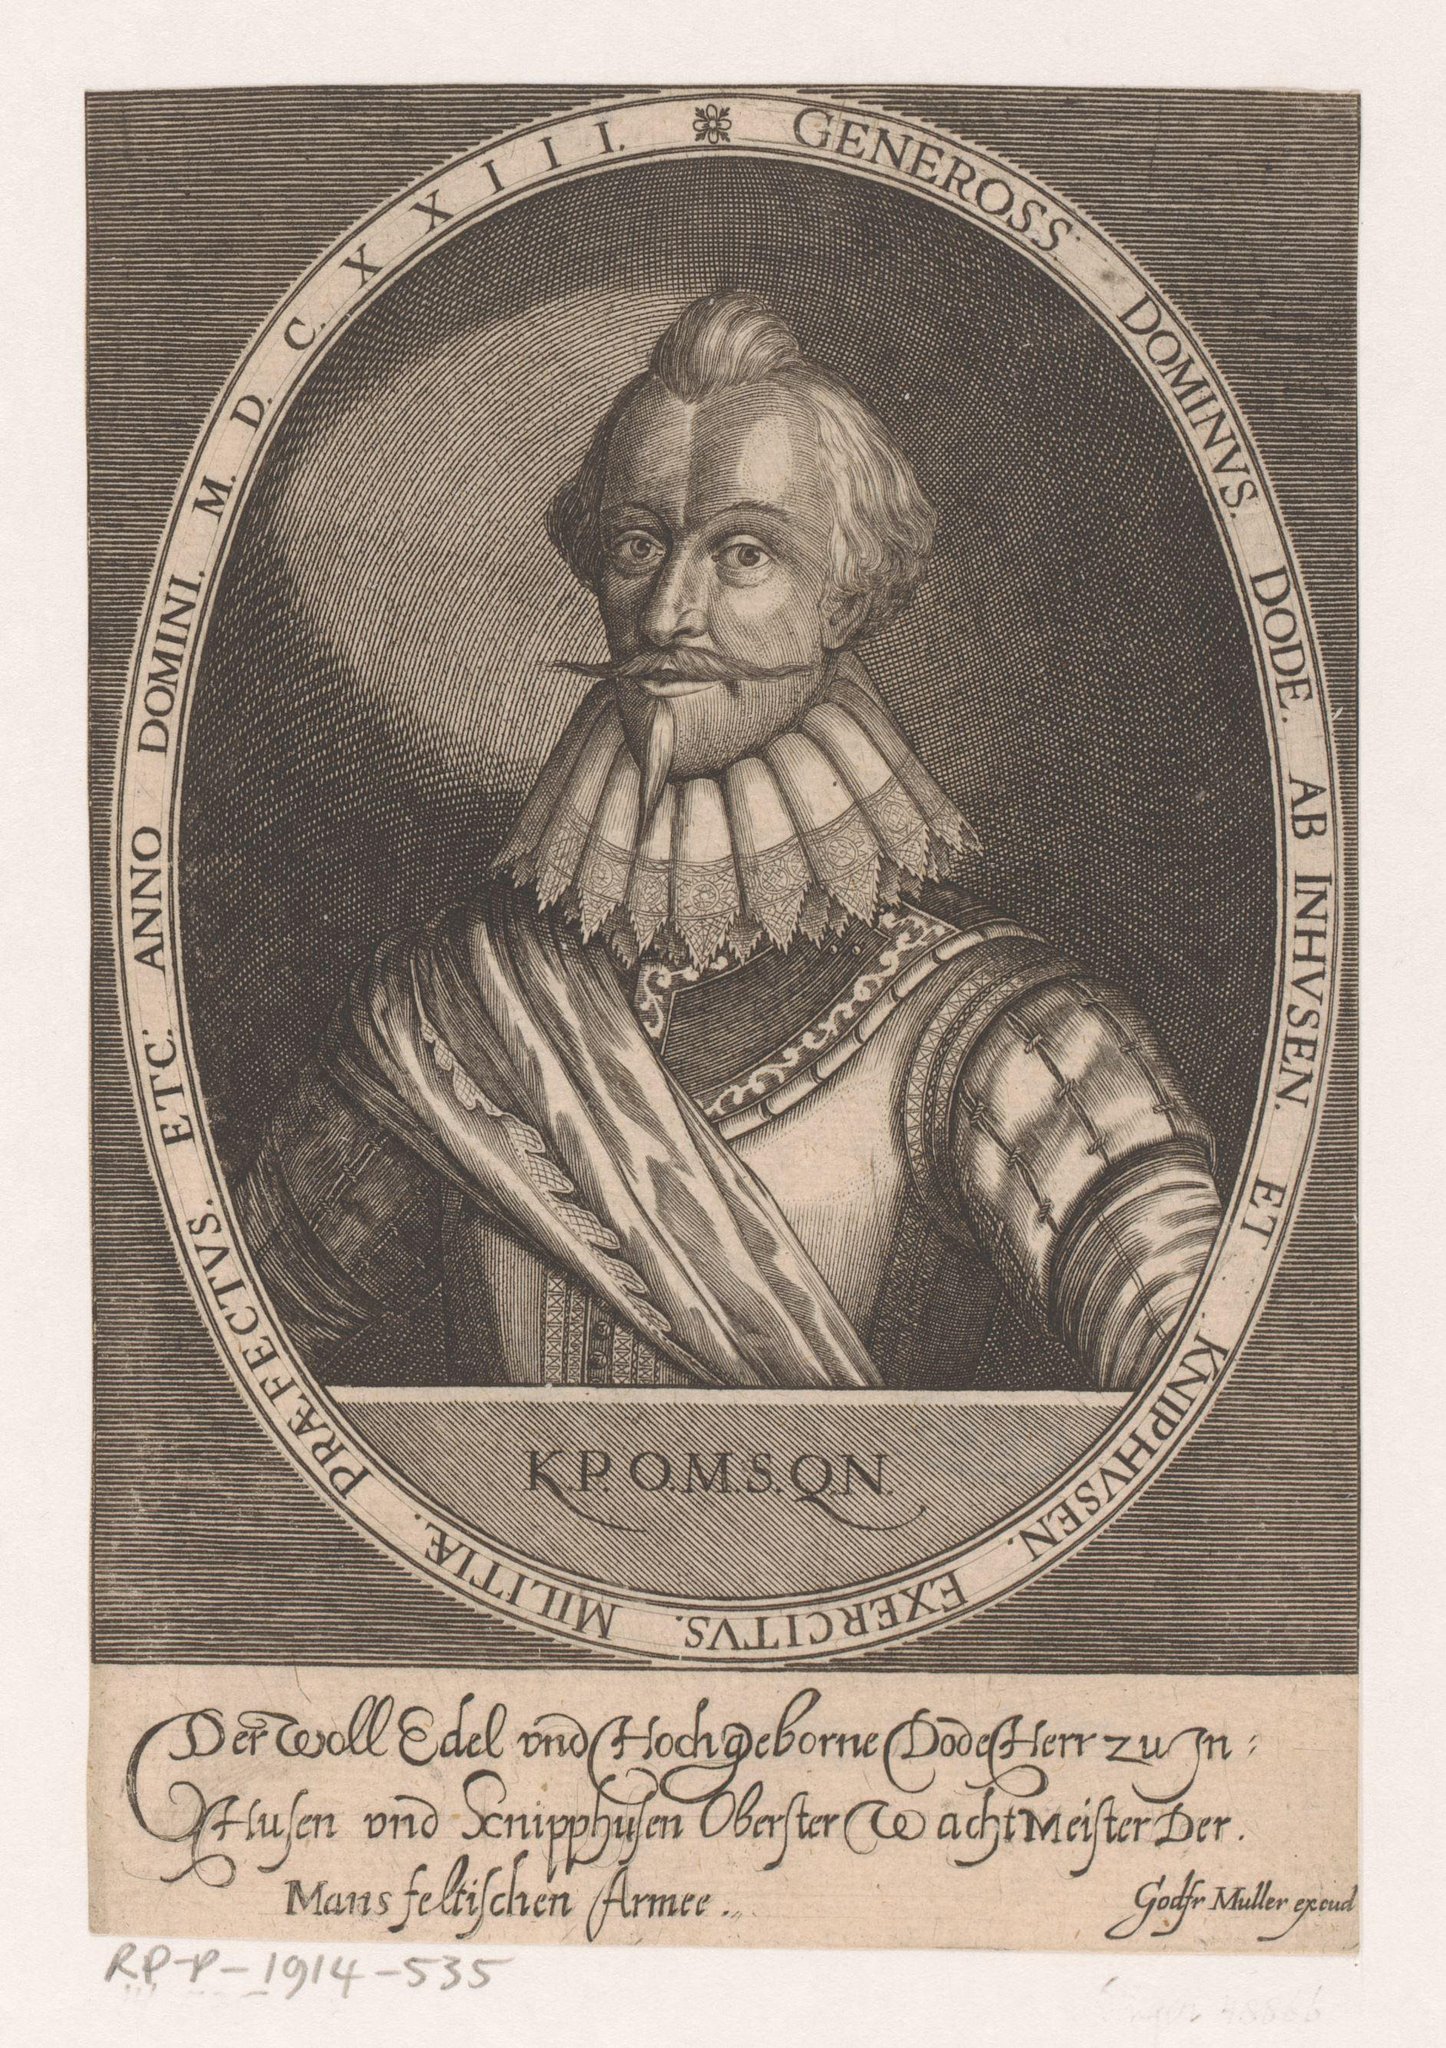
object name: print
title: Portret van Dodo zu Innhausen und Knyphausen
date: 1620-1656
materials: paper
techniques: engraving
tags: germany, armour, historical persons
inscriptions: collector's mark: Lugt 2228